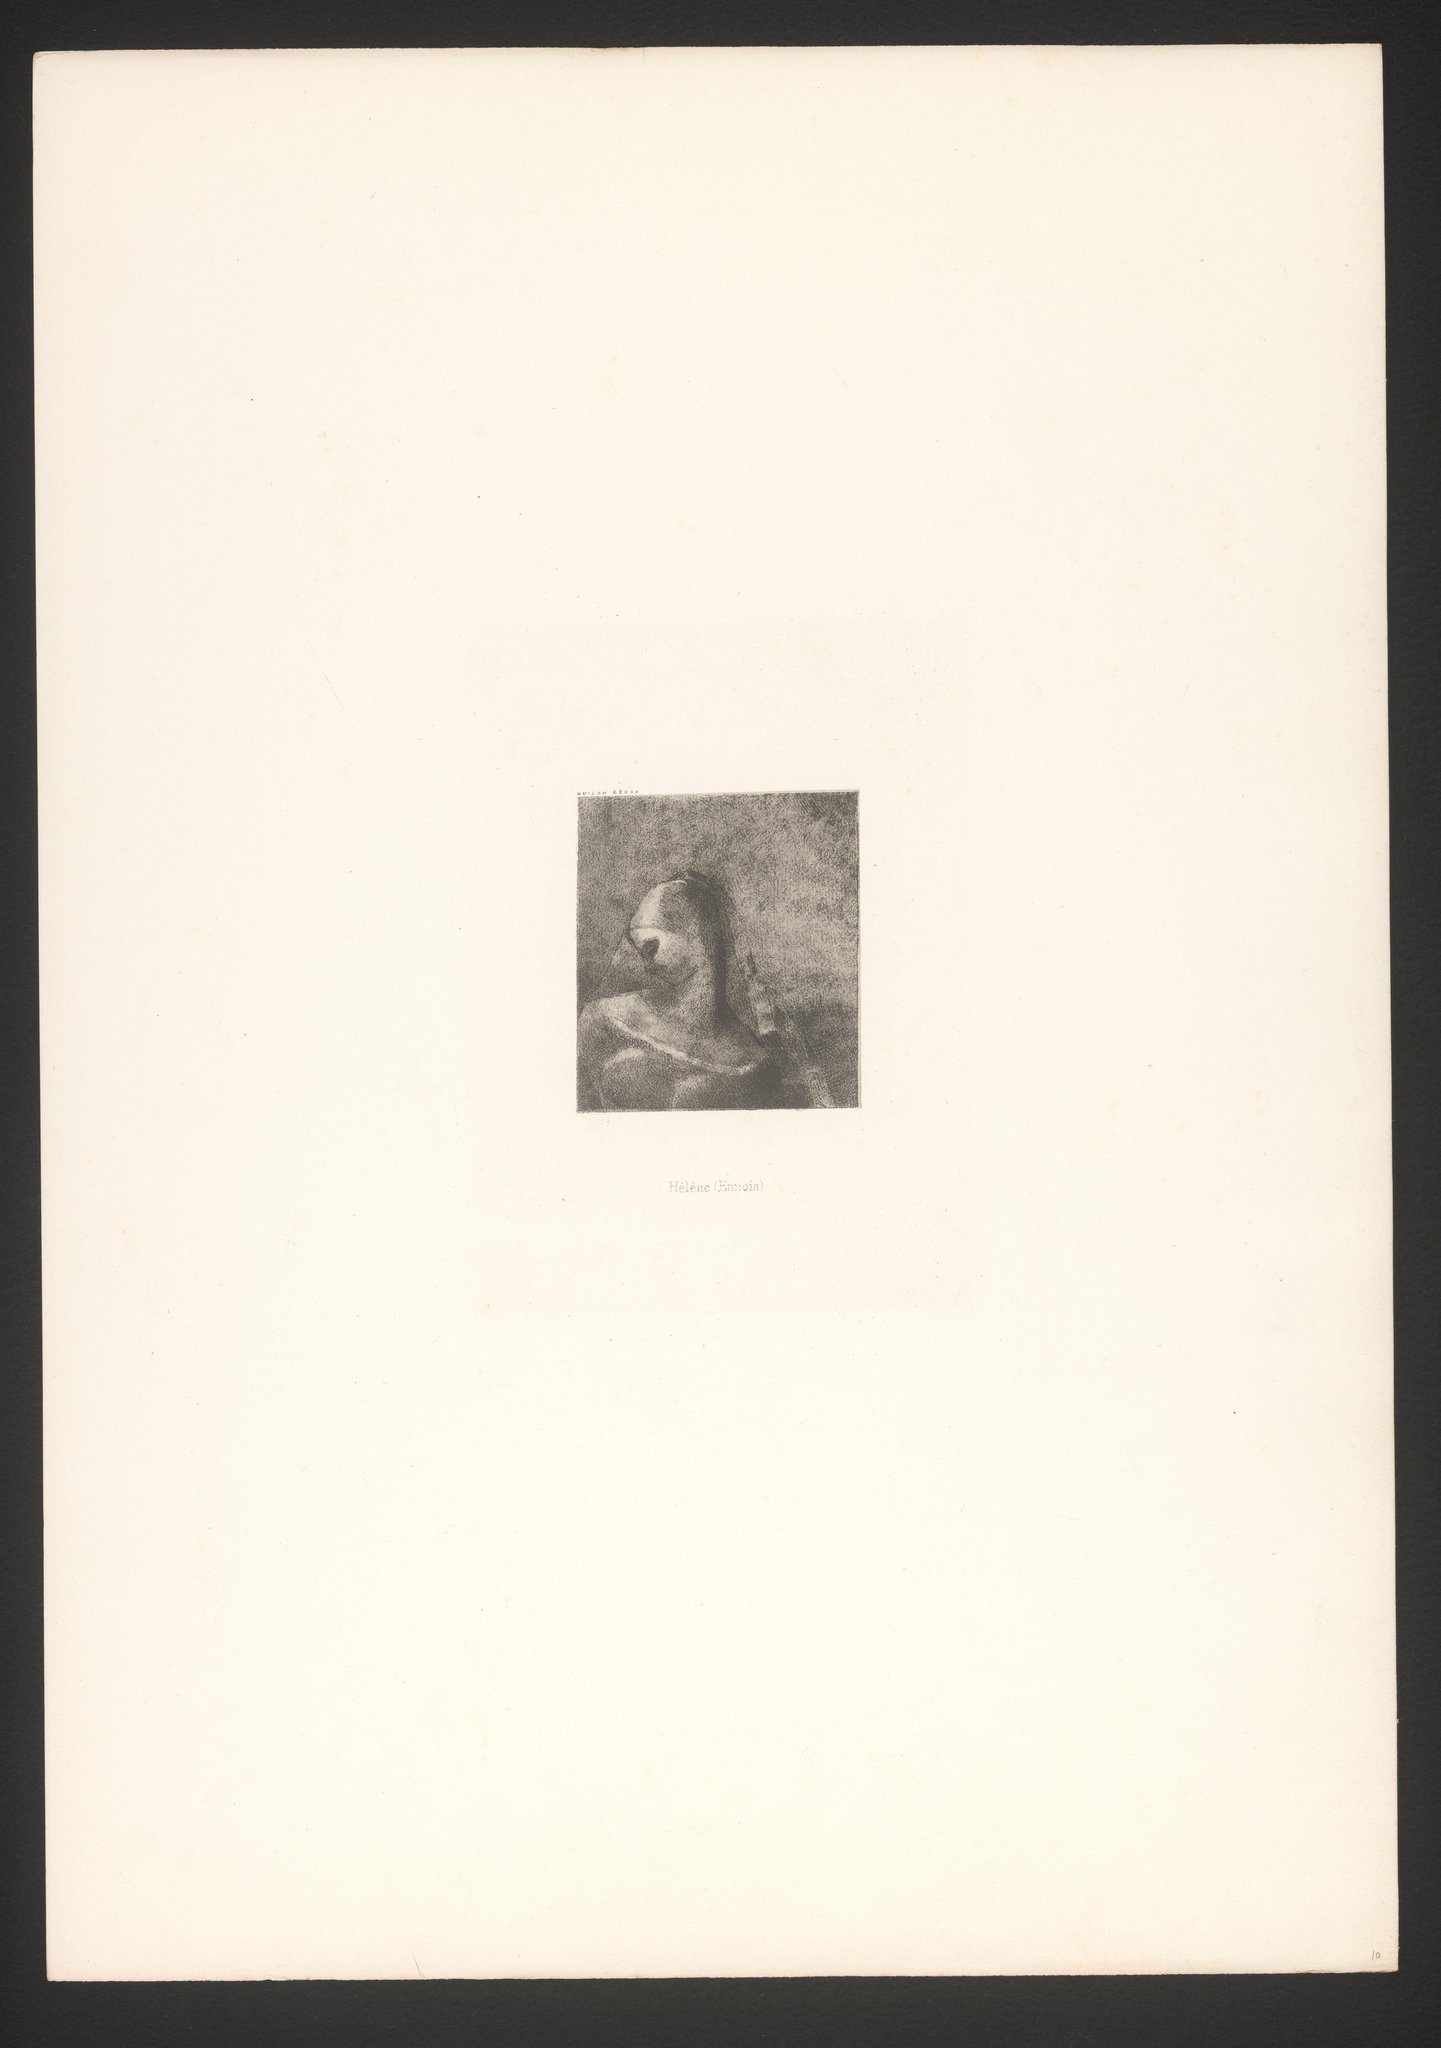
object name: print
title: Gesluierde vrouw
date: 1896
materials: paper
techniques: lithograph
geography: paris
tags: adult woman, veil